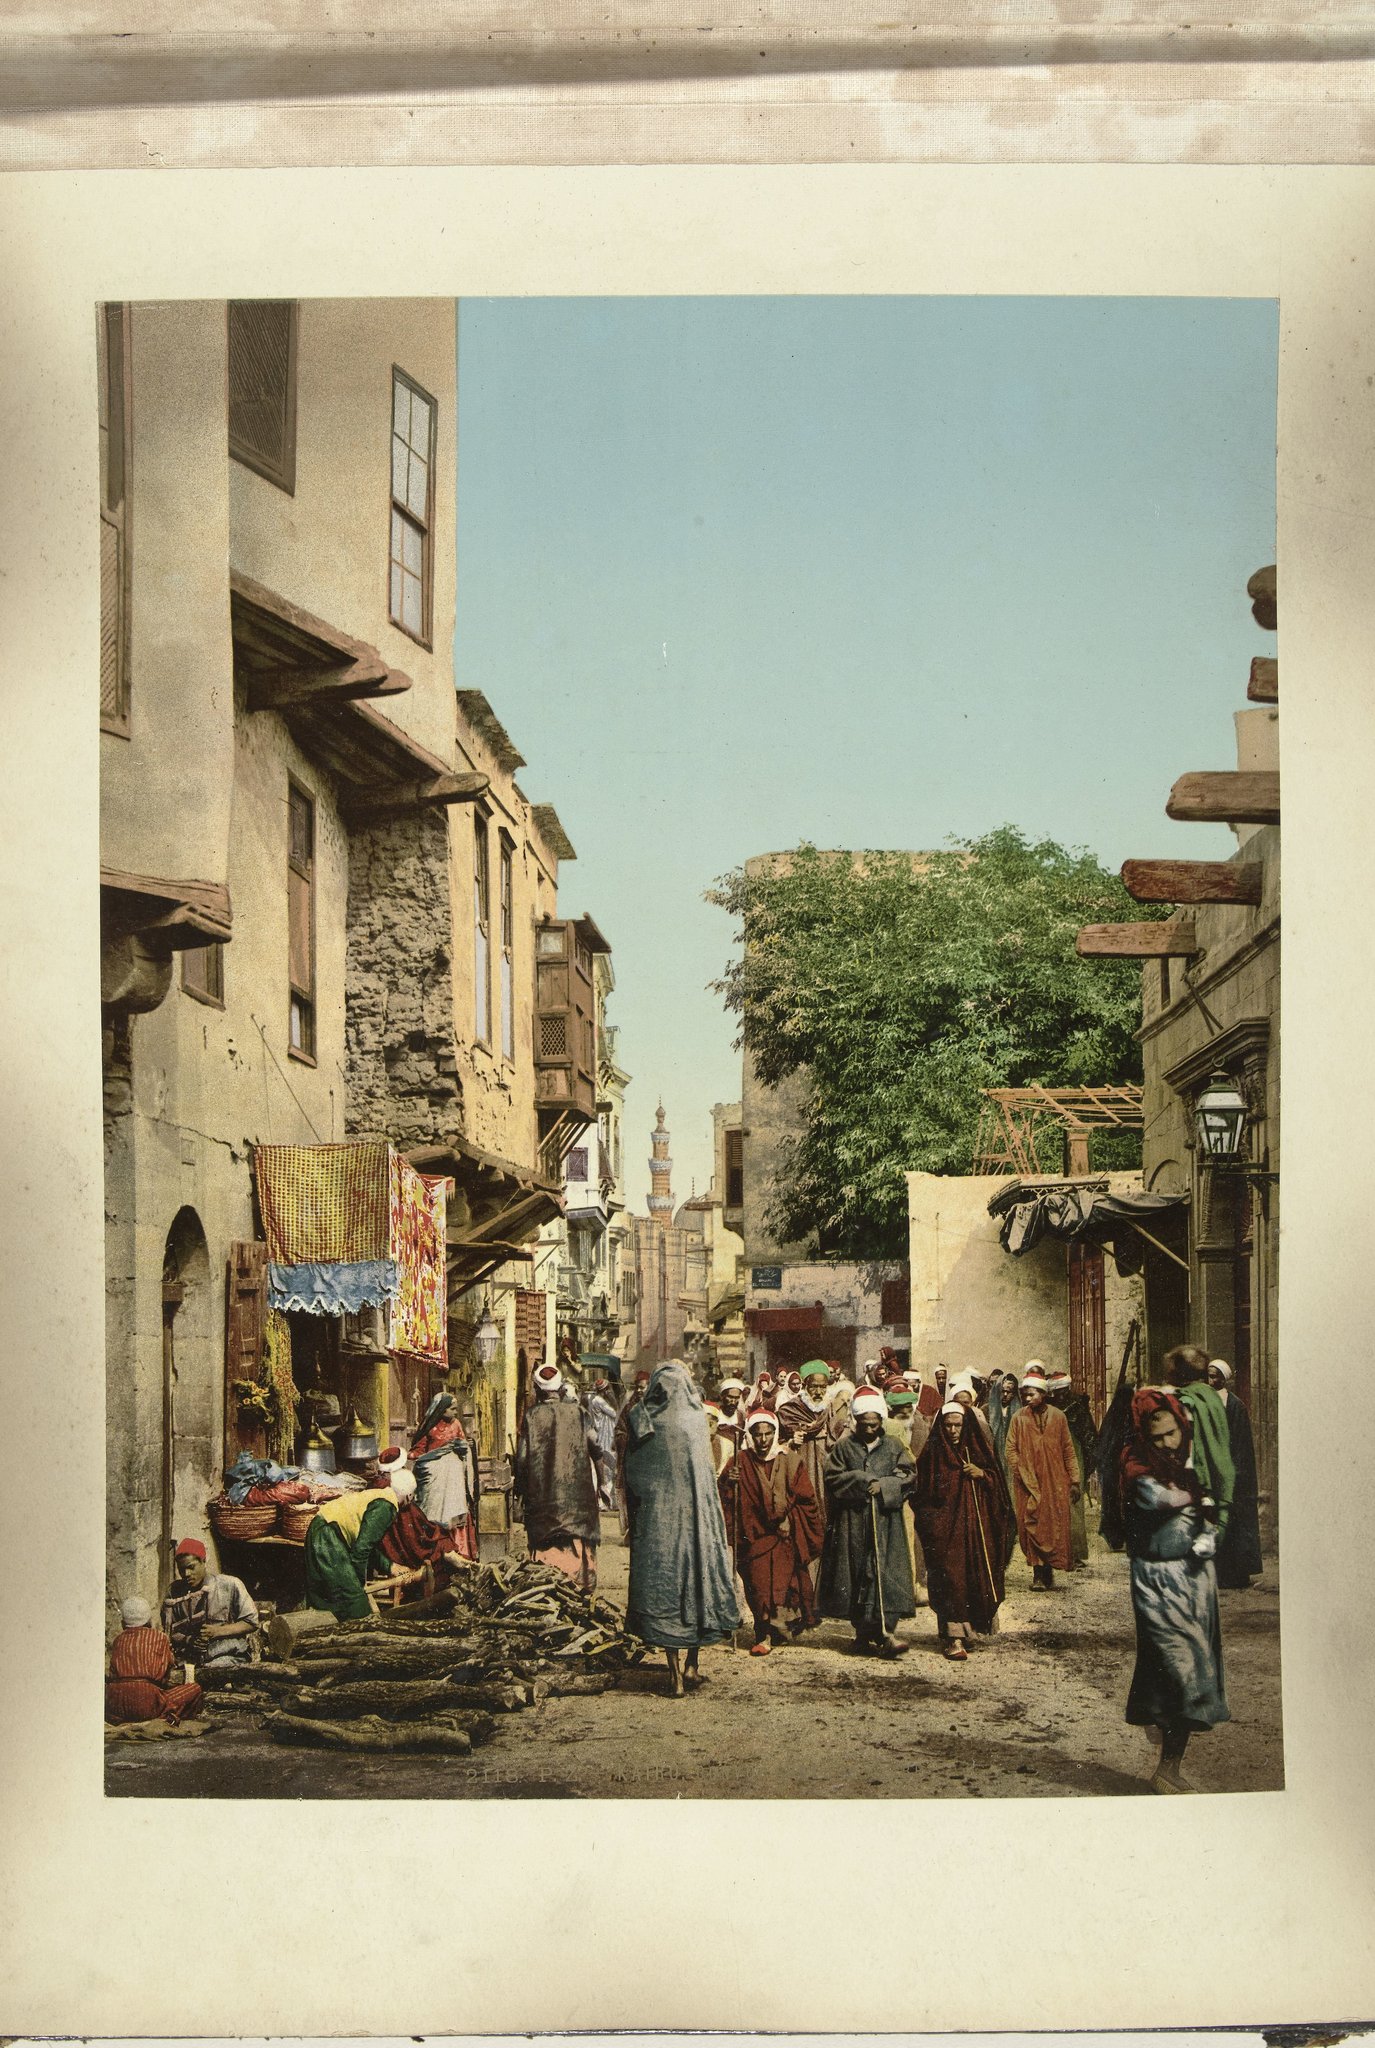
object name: album leaf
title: Convoi funeure arabe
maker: Anonymous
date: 1895-1910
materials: paper, photographic process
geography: cairo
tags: cortege, funeral procession, street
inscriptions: number: ‘2118.’, name: ‘P.Z.’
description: De ingekleurde foto toont mensen op straat, het merendeel in lange kleding en met hoofddeksel.